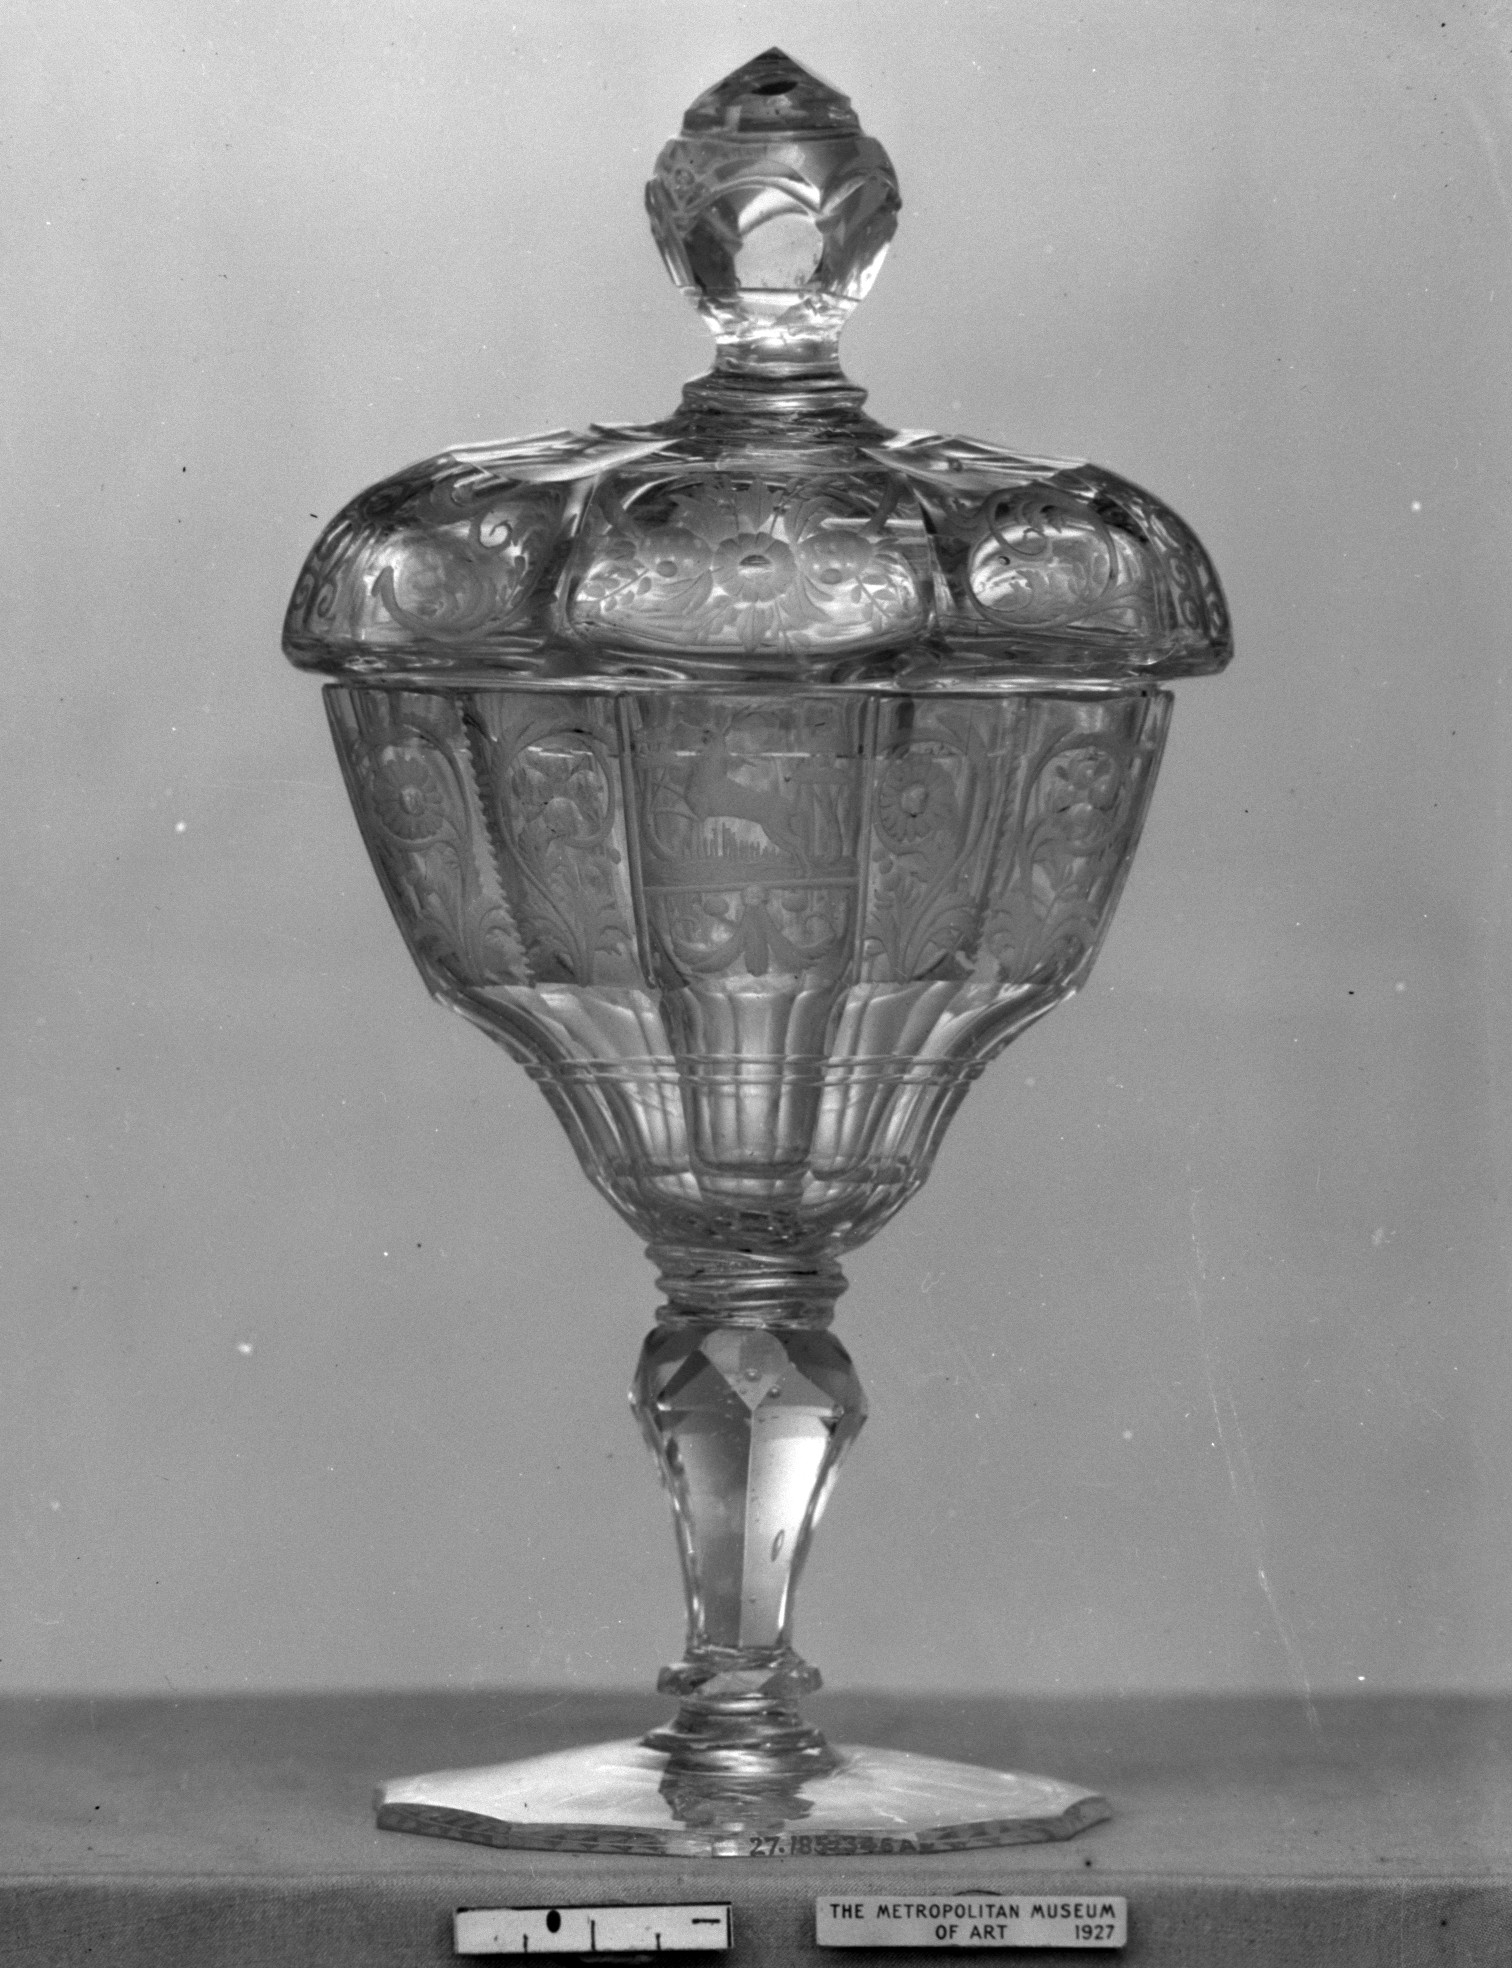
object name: sweetmeat glass with cover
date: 1730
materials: glass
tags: deer,flowers